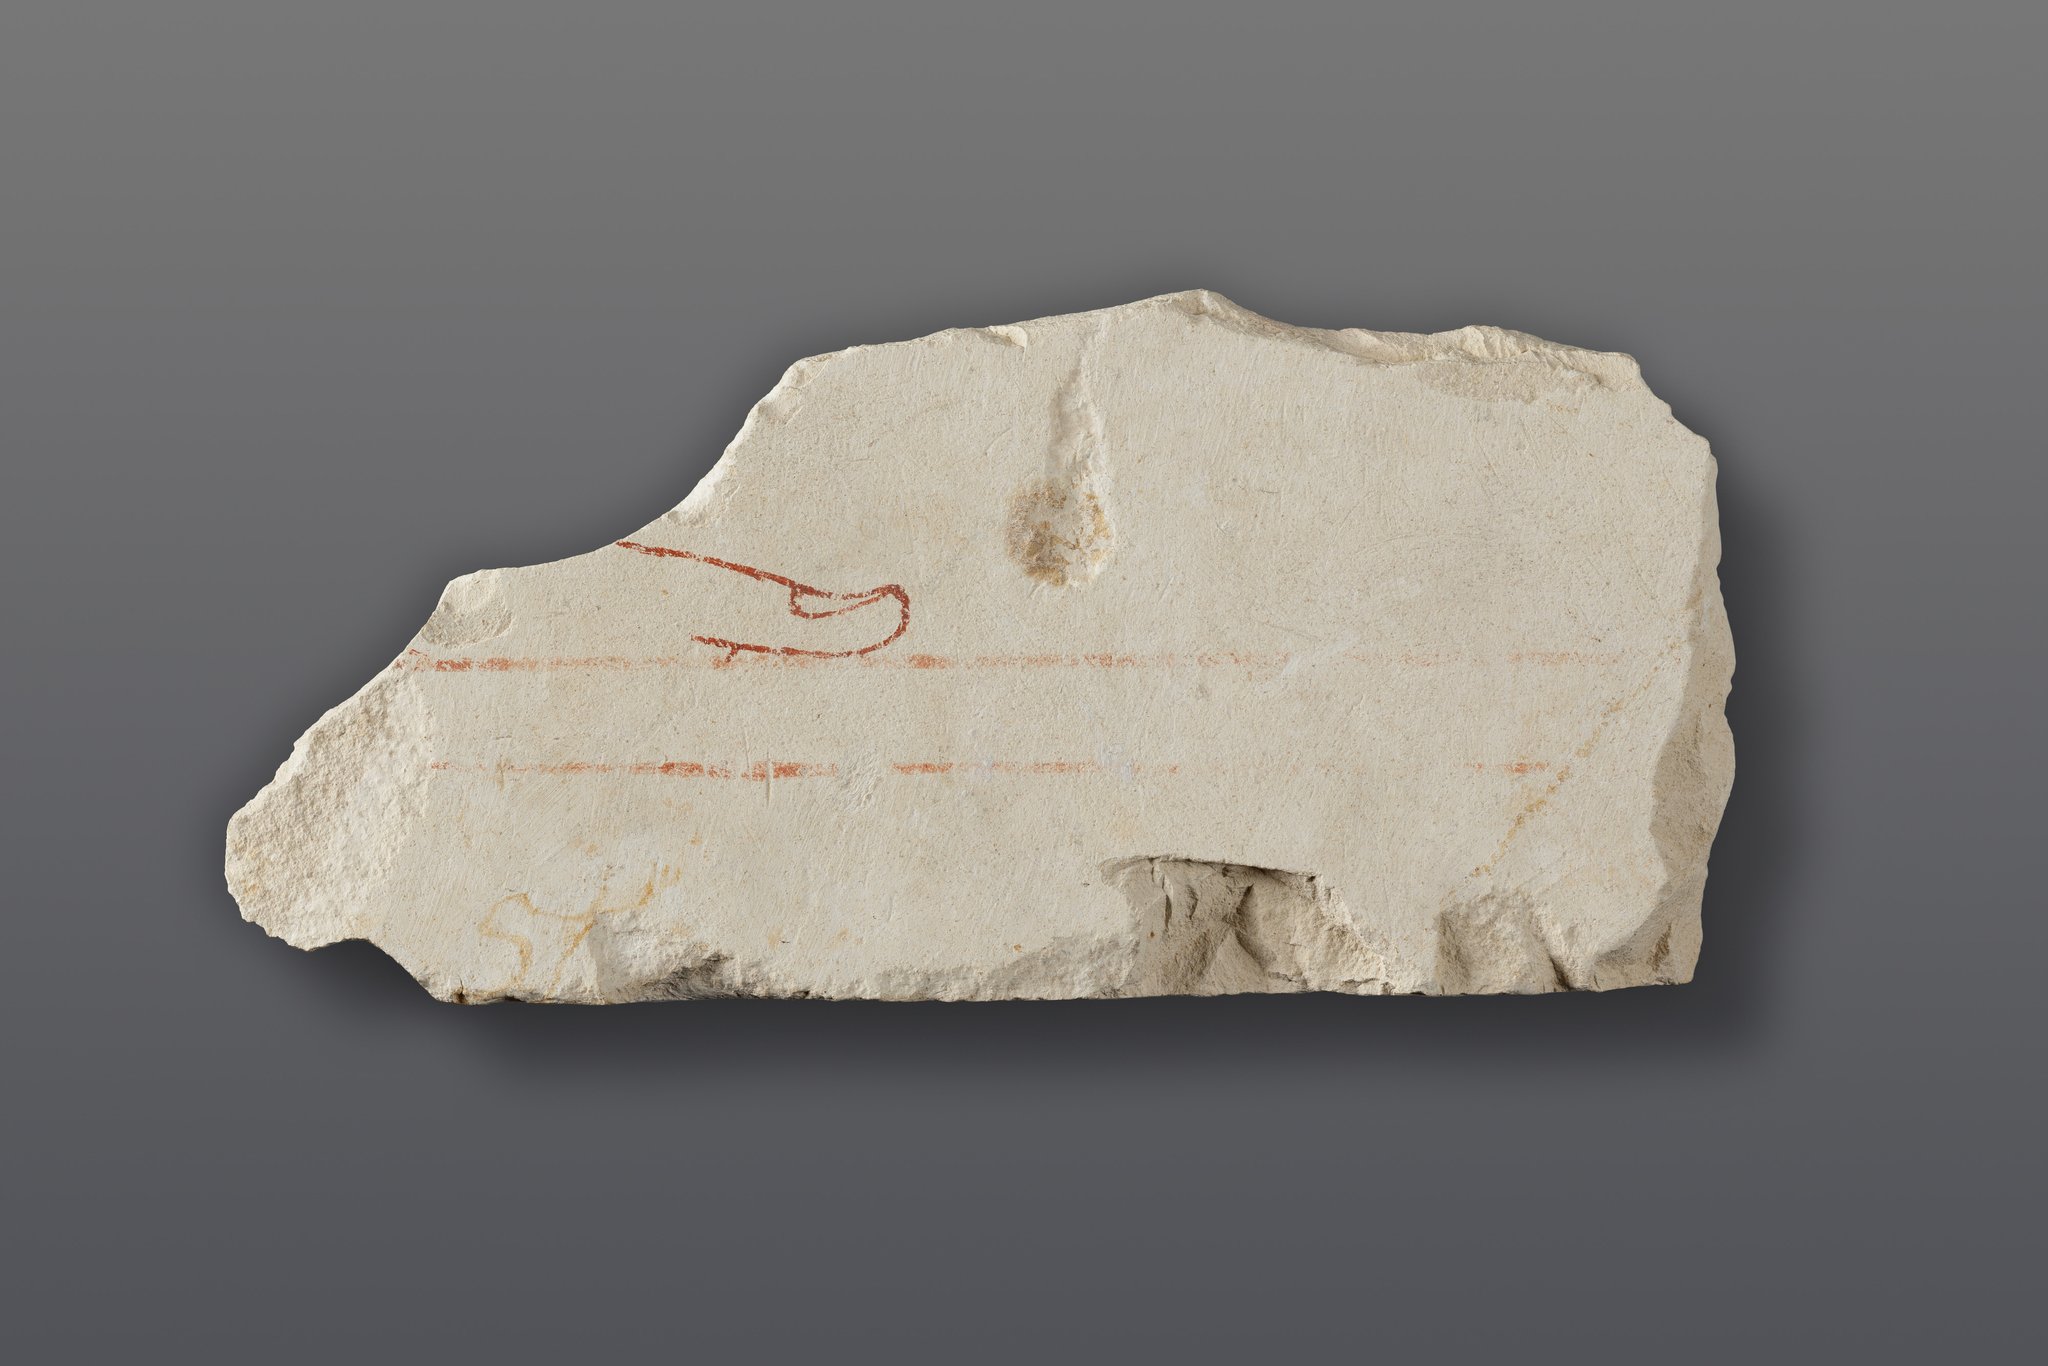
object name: relief drawing, sebeknakhte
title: Preliminary drawing for a relief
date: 2124-1504 BCE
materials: limestone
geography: egypt